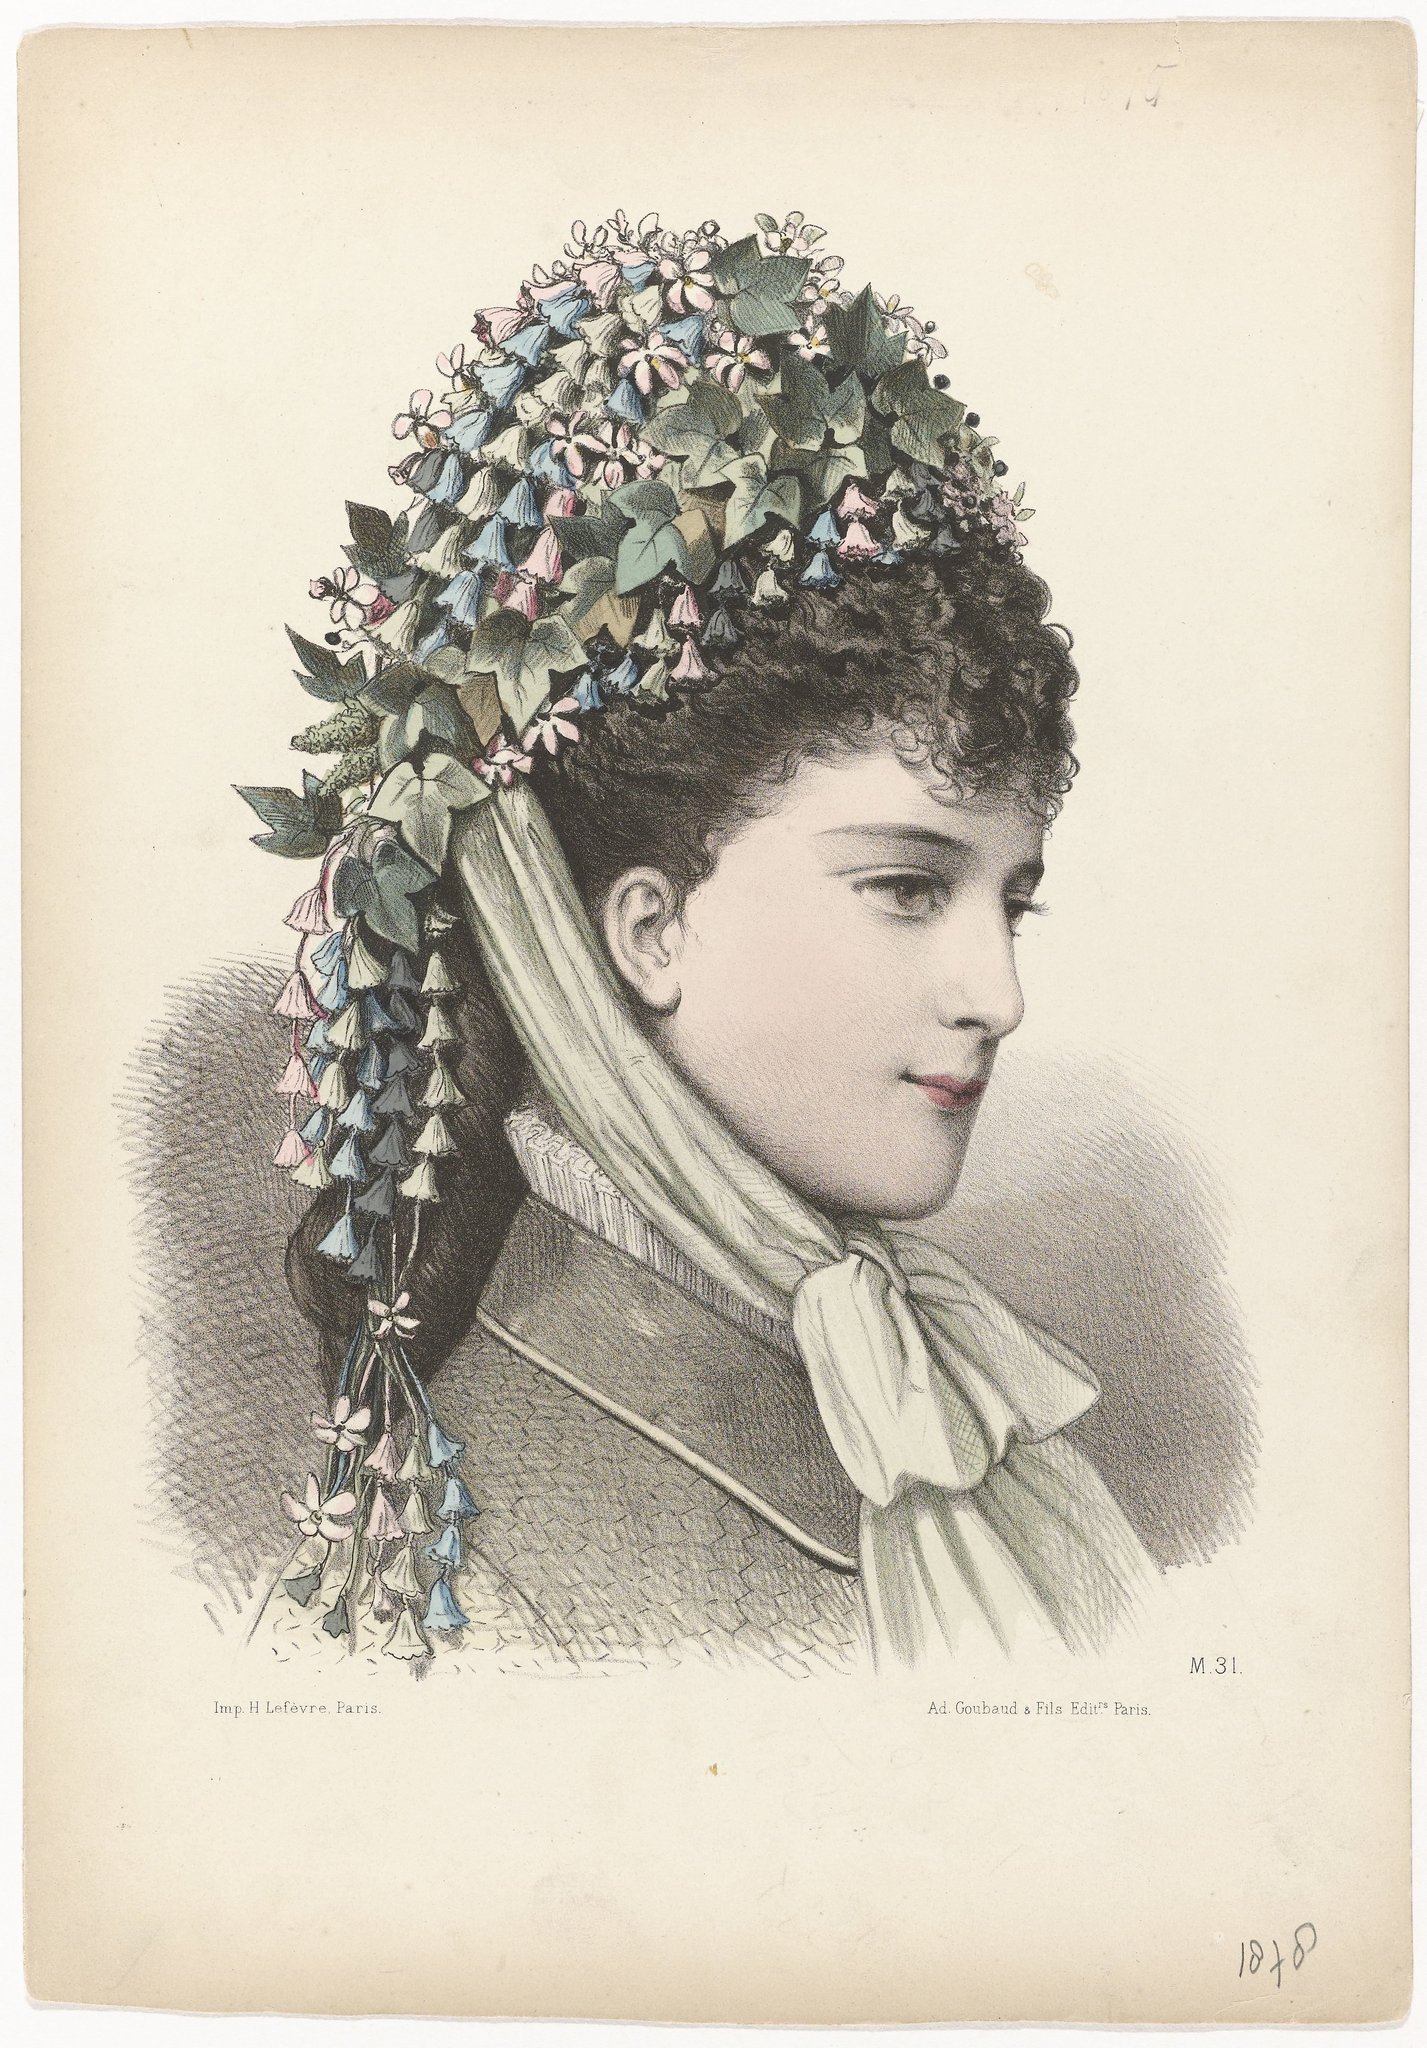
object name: fashion print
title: Vrouwenhoofd met hoed met klimop, 1875, No. M.31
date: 1875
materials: paper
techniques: hand coloring, lithograph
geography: paris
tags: flowers, border, ribbon, braid (+ women's clothes), head-gear (+ women's clothes), fashion plates, plants and herbs: ivy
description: Vrouwenhoofd met een hoed versierd met bloemen, klimop en striklinten, die onder de kin zijn vastgemaakt.